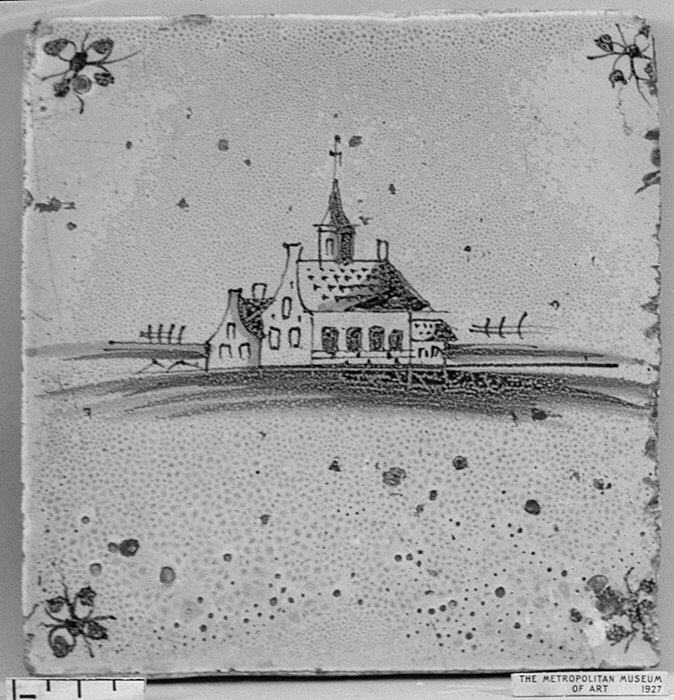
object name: tile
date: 1701-1800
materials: earthenware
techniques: glazing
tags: houses